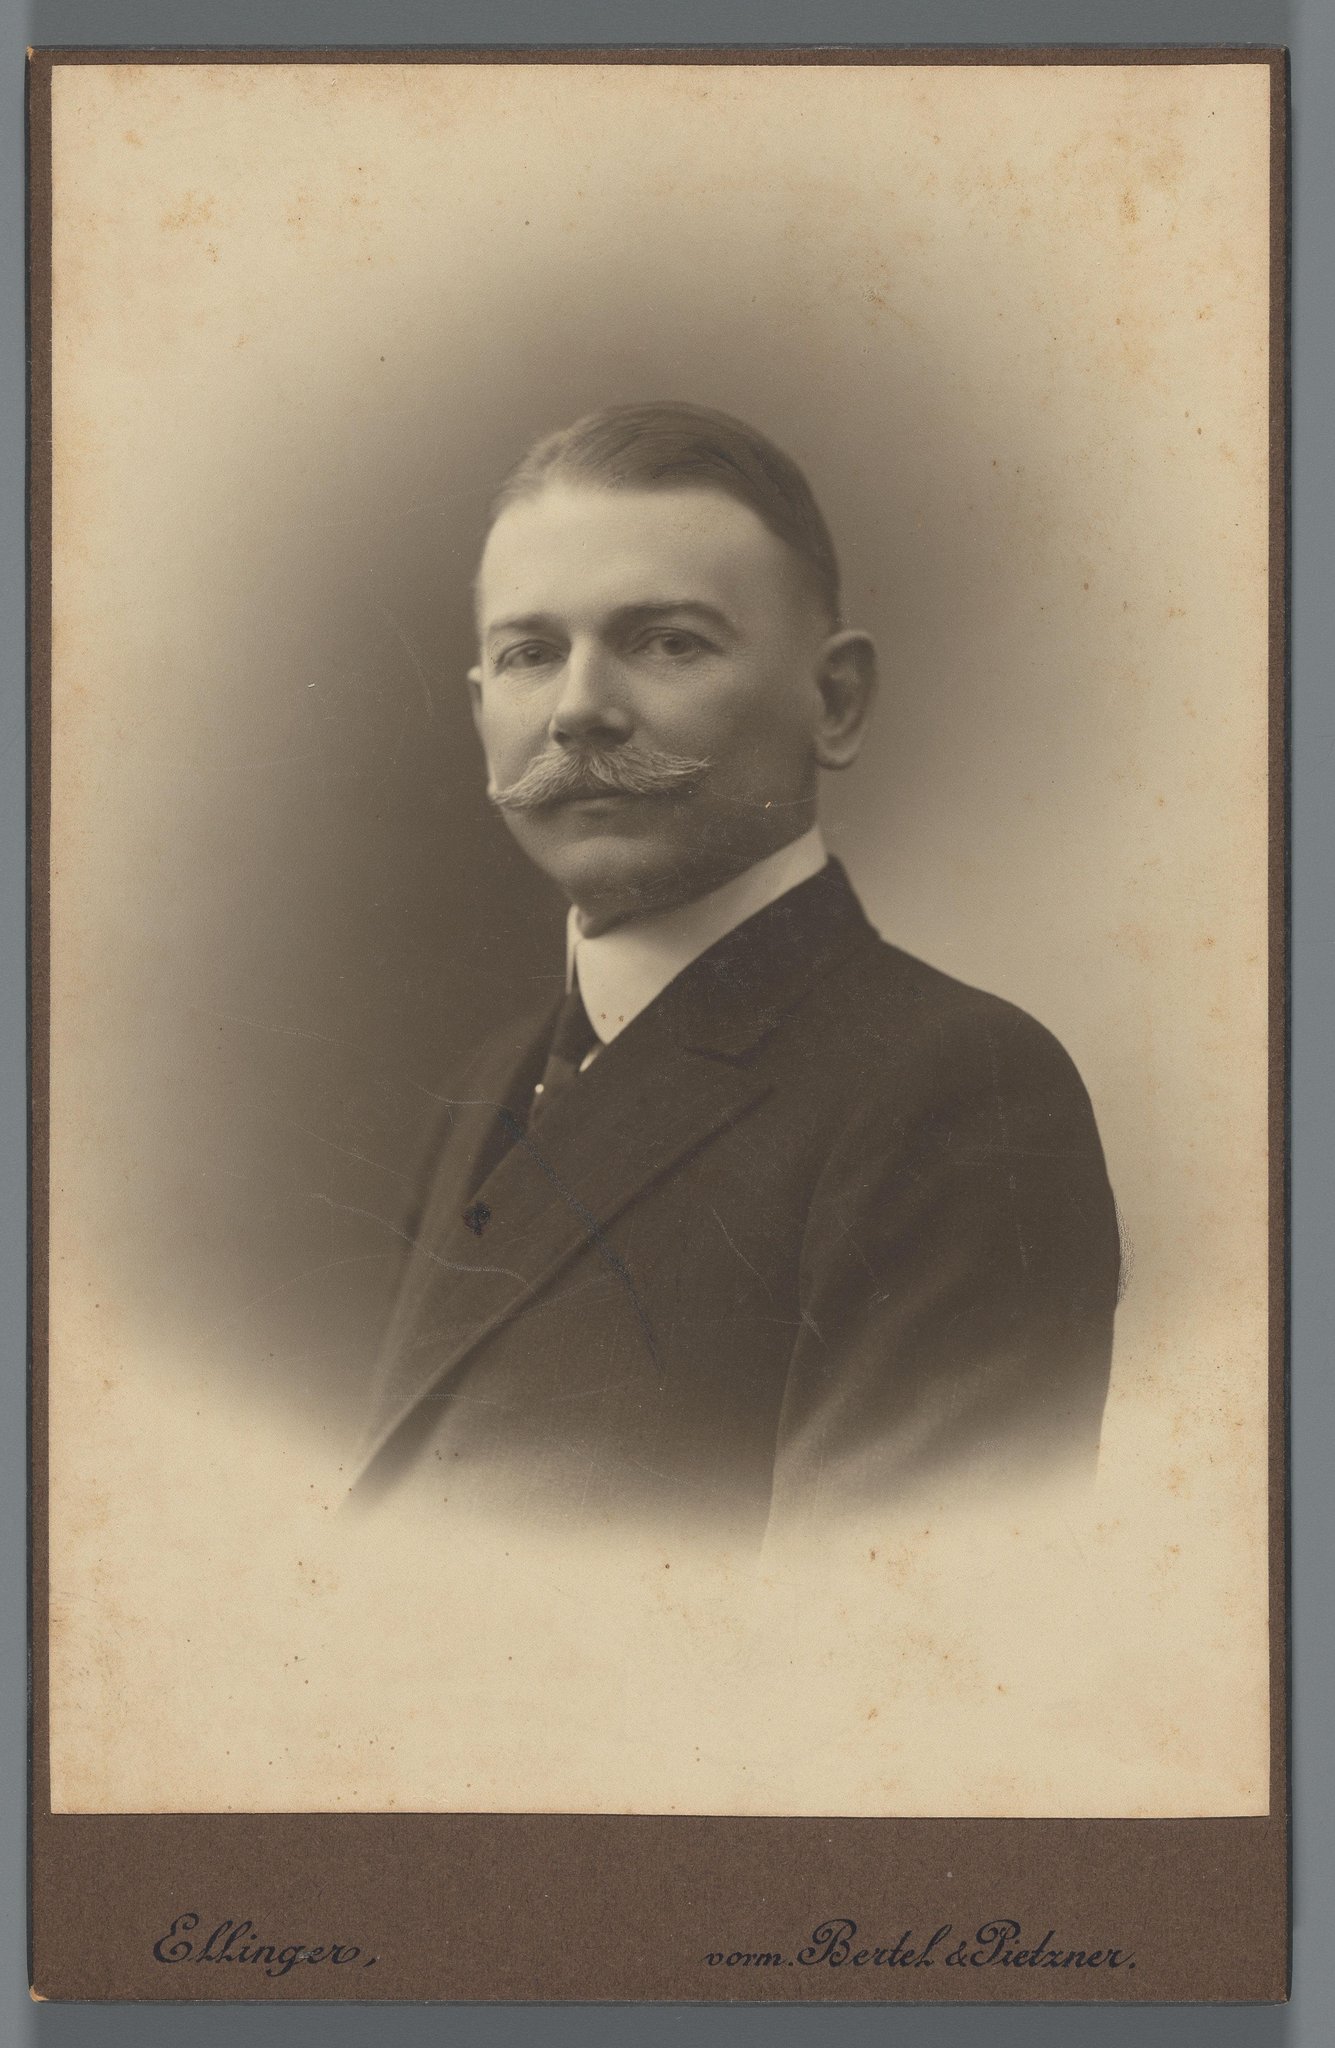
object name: cabinet photograph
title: Portret van Frans Alexander van den Berg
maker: carl ellinger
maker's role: fotograaf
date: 1880-1914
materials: cardboard, photographic support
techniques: albumen print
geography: salzburg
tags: batavia, amsterdam, frans alexander van den berg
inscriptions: name: ‘Ellinger, vorm. Bertel & Pietzner.’, name: ‘Carl Ellinger / vorm. Bertel & Pietzner / K. u K. Hof- und Kammer-Photographen / Salzburg / Schwarzstrasse No. 9’, inscription: ‘F. A. van den Berg’